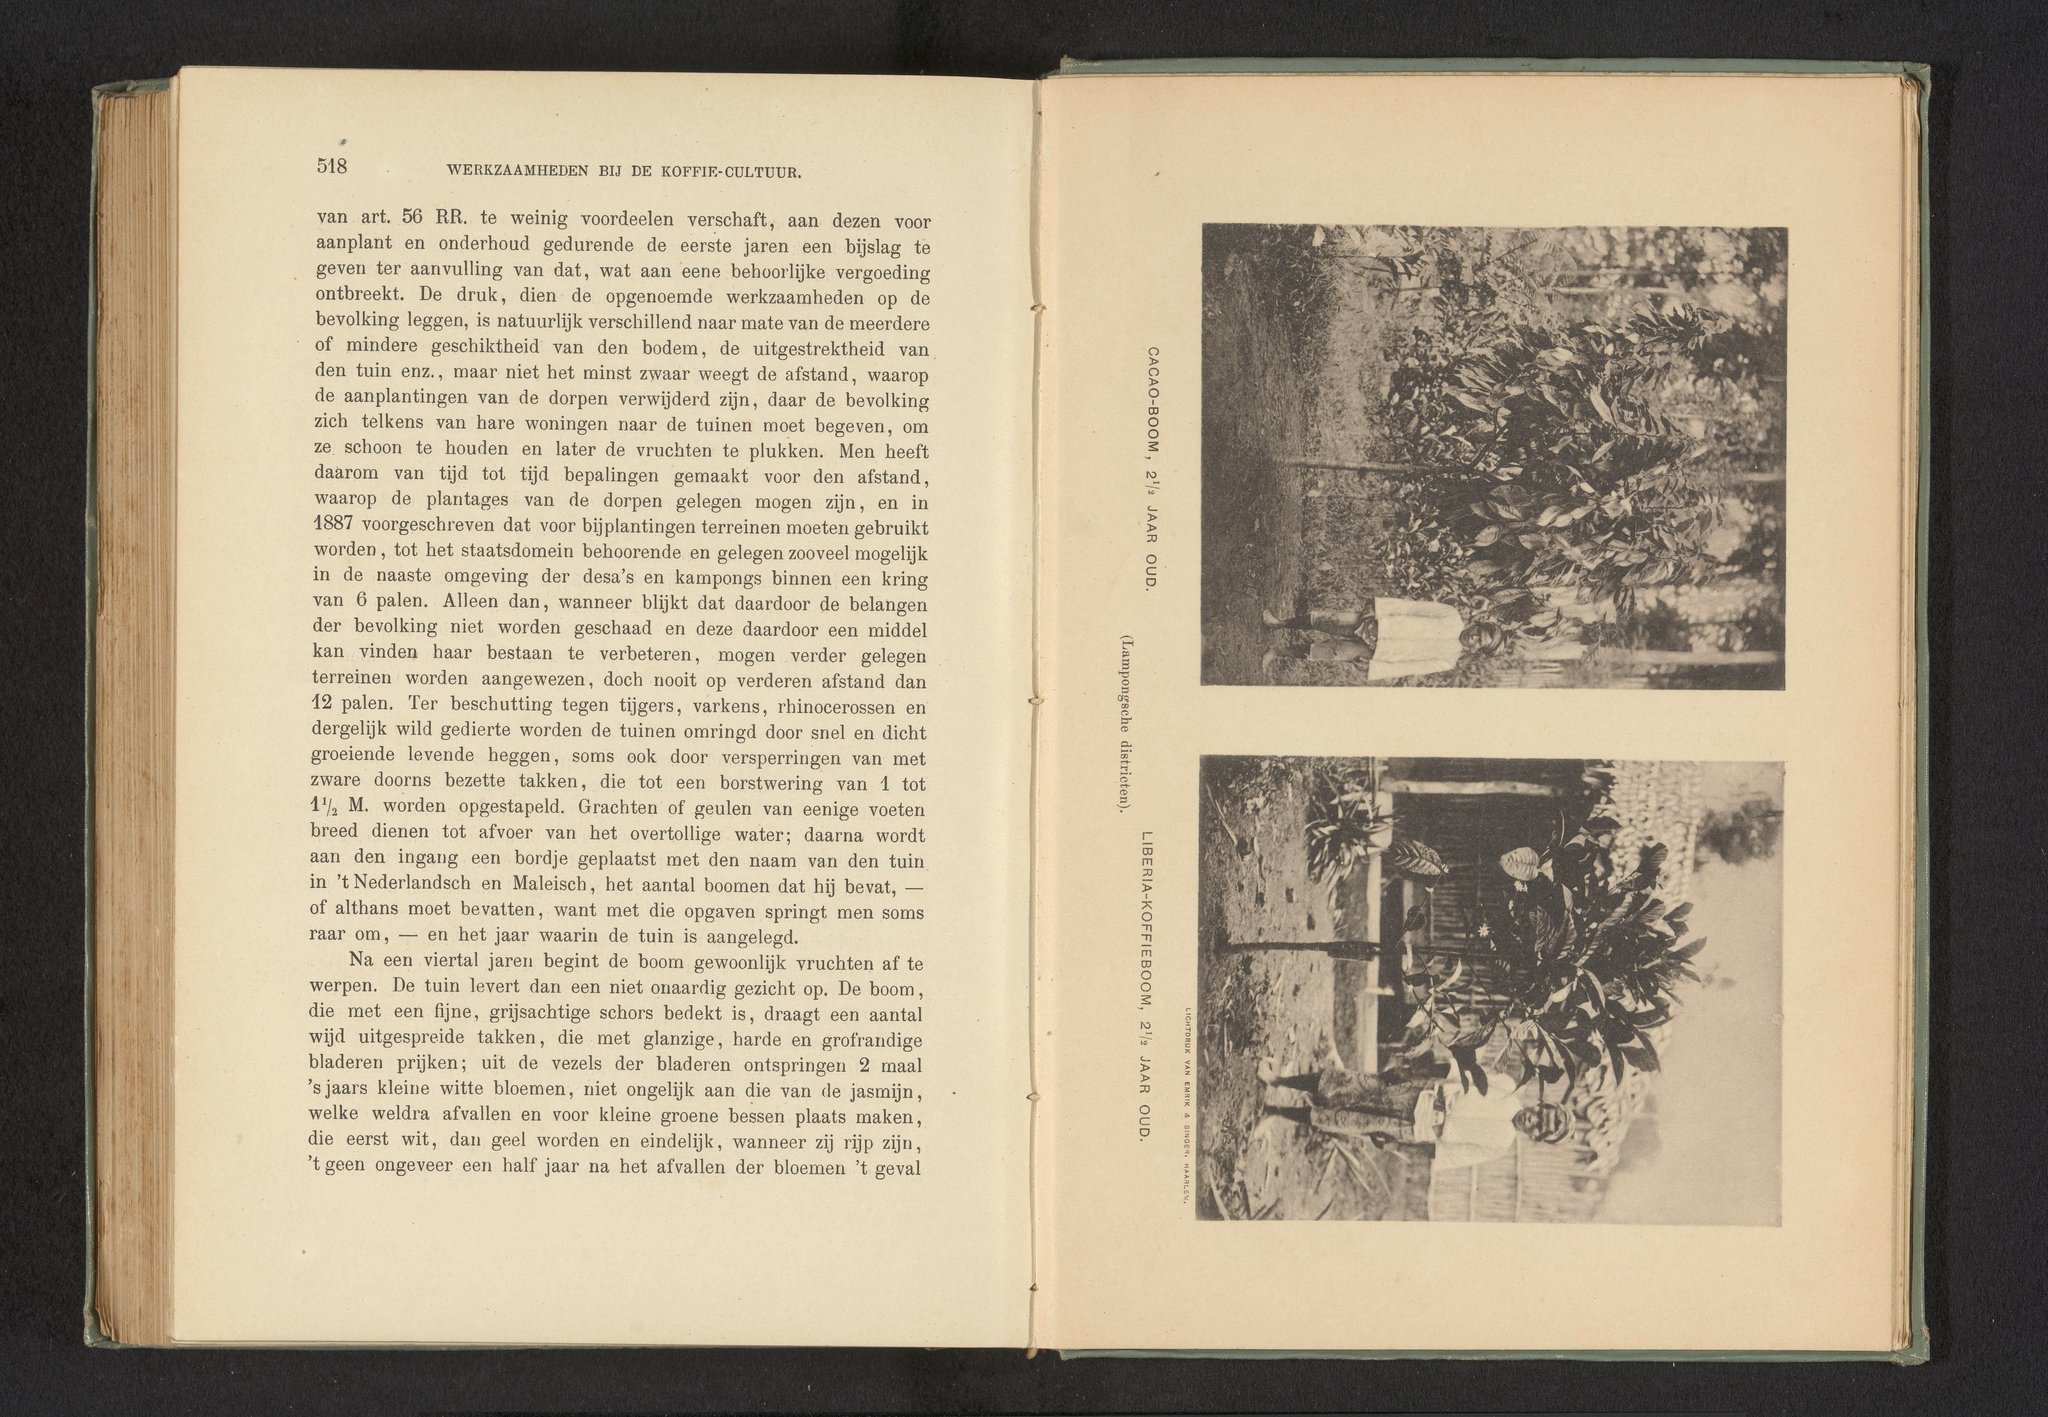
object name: photomechanical print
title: Man naast een cacaoboom en een koffieboom in Nederlands Oost-Indië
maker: Anonymous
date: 1883-1894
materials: paper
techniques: photograph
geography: dutch east indies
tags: plantation